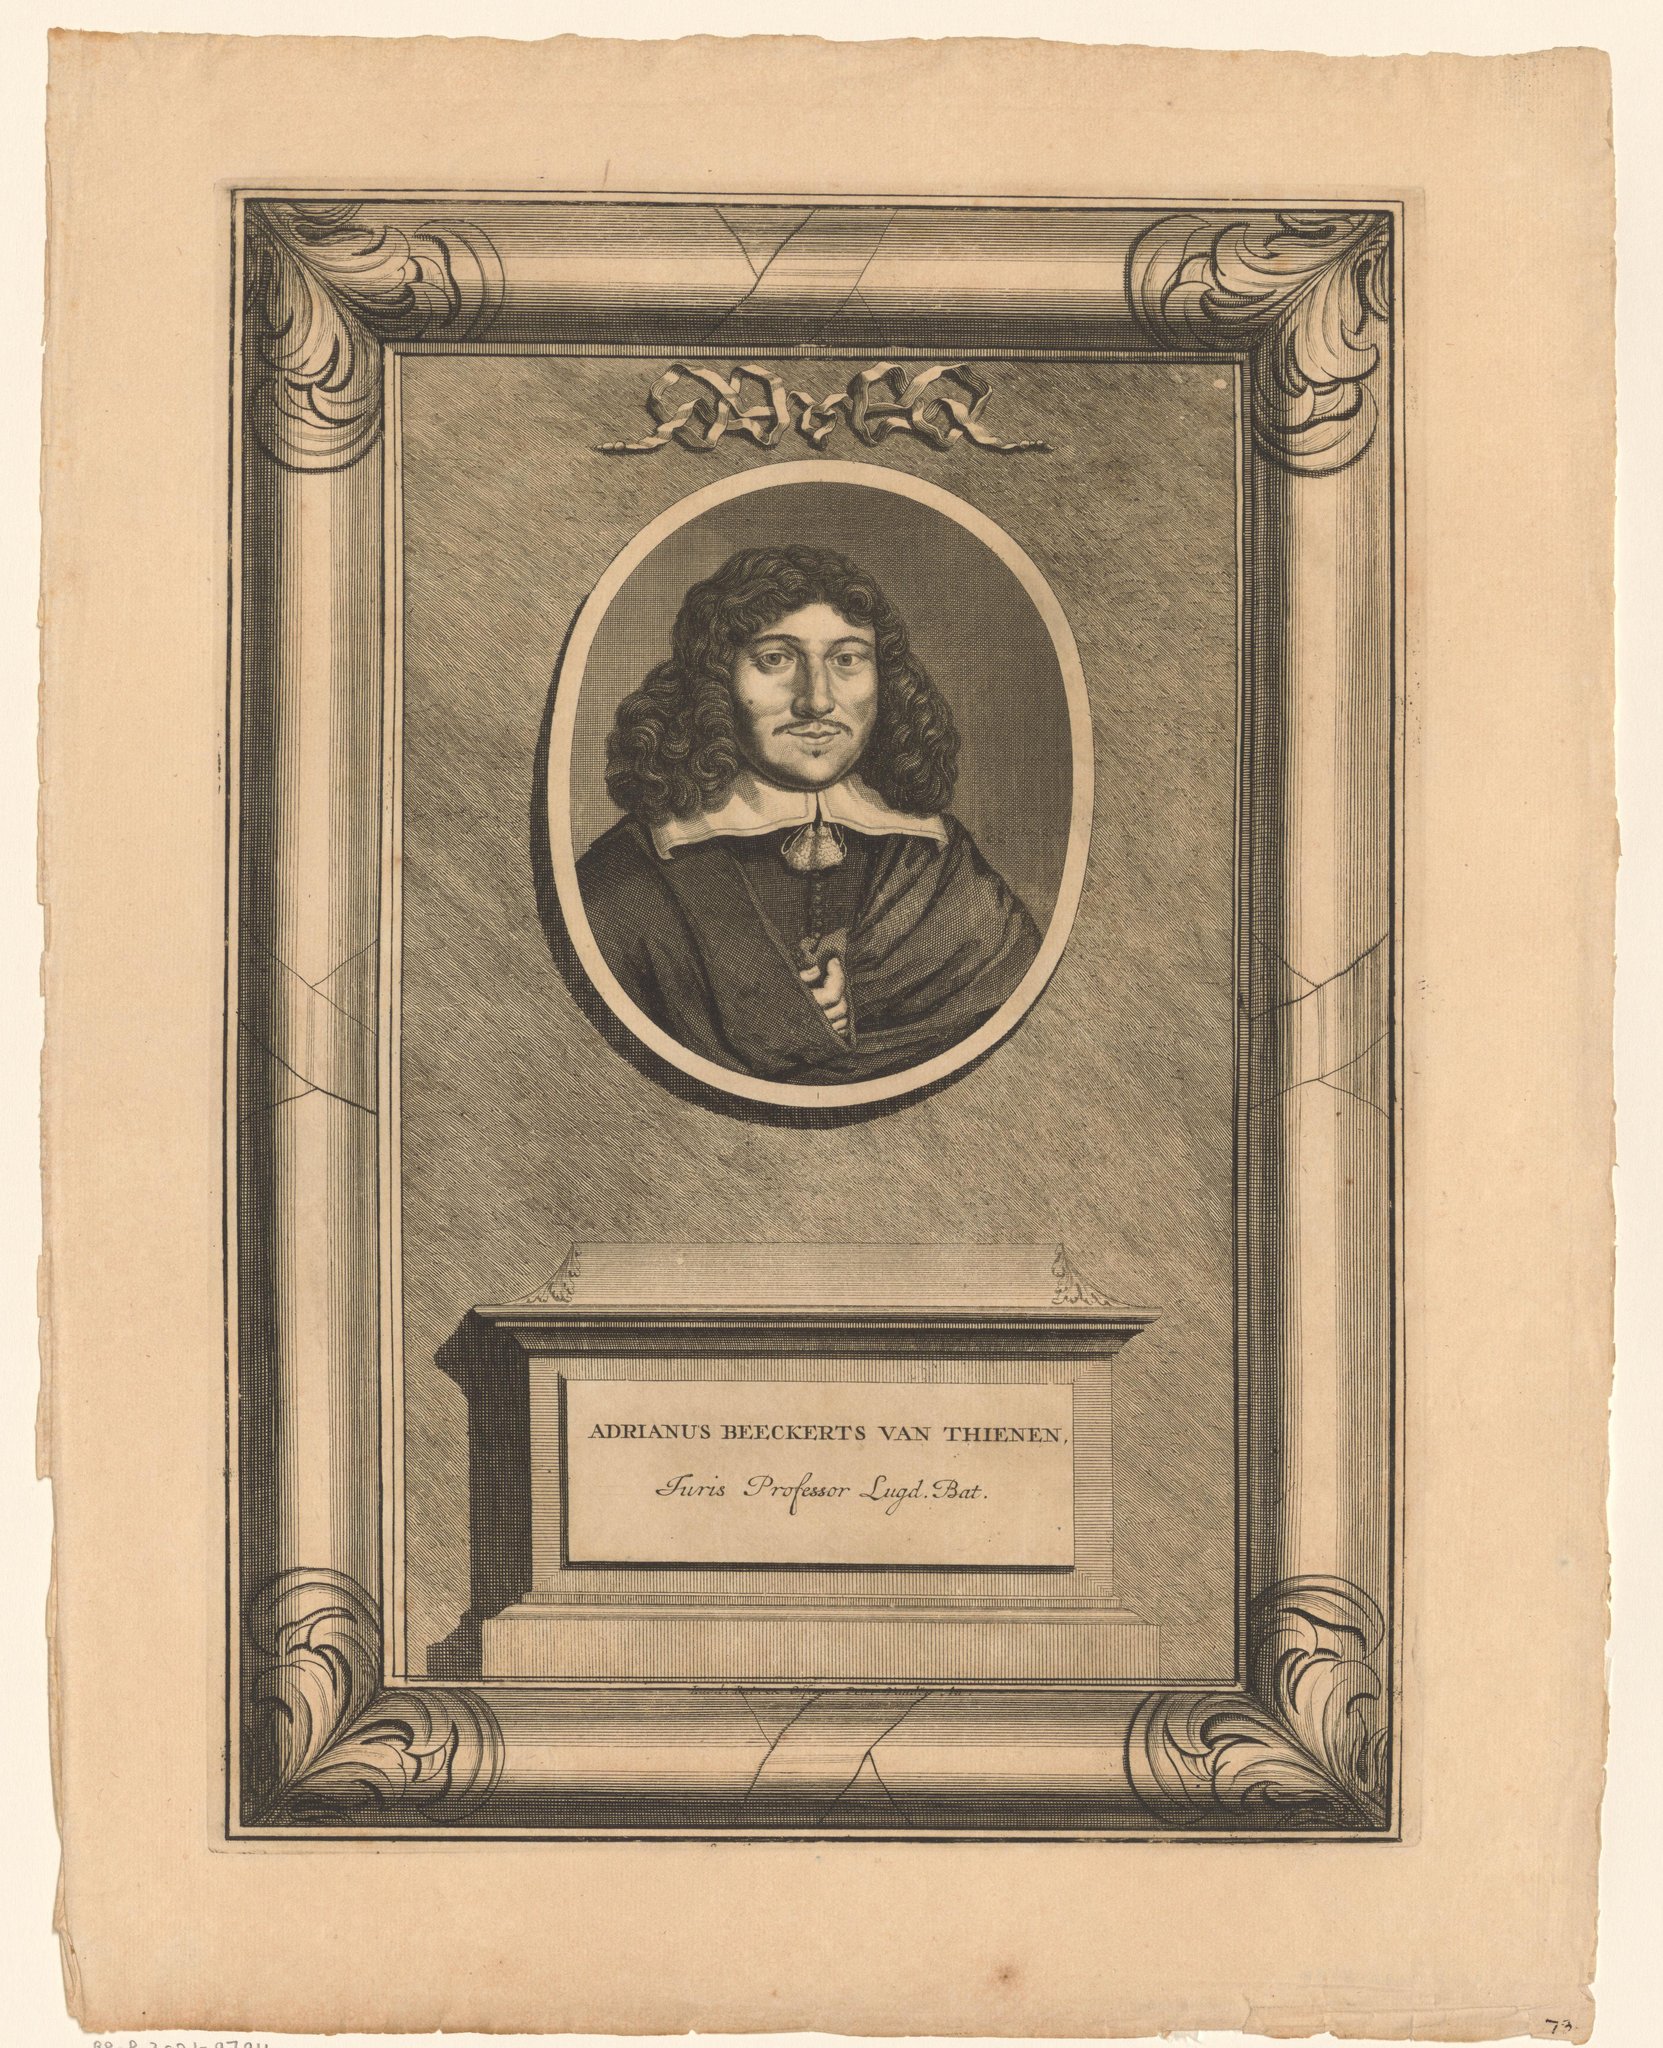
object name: print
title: Portret van Adriaan Beeckerts van Thienen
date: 1668-1733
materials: paper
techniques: engraving, etching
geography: leiden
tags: leiden, historical persons, professor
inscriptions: collector's mark: Lugt 2228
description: Prent zonder omlijsting gebruikt in: Fundatoris, curatorum et professorum celeberrimorum (...). Leiden: Pieter van der Aa, 1716.